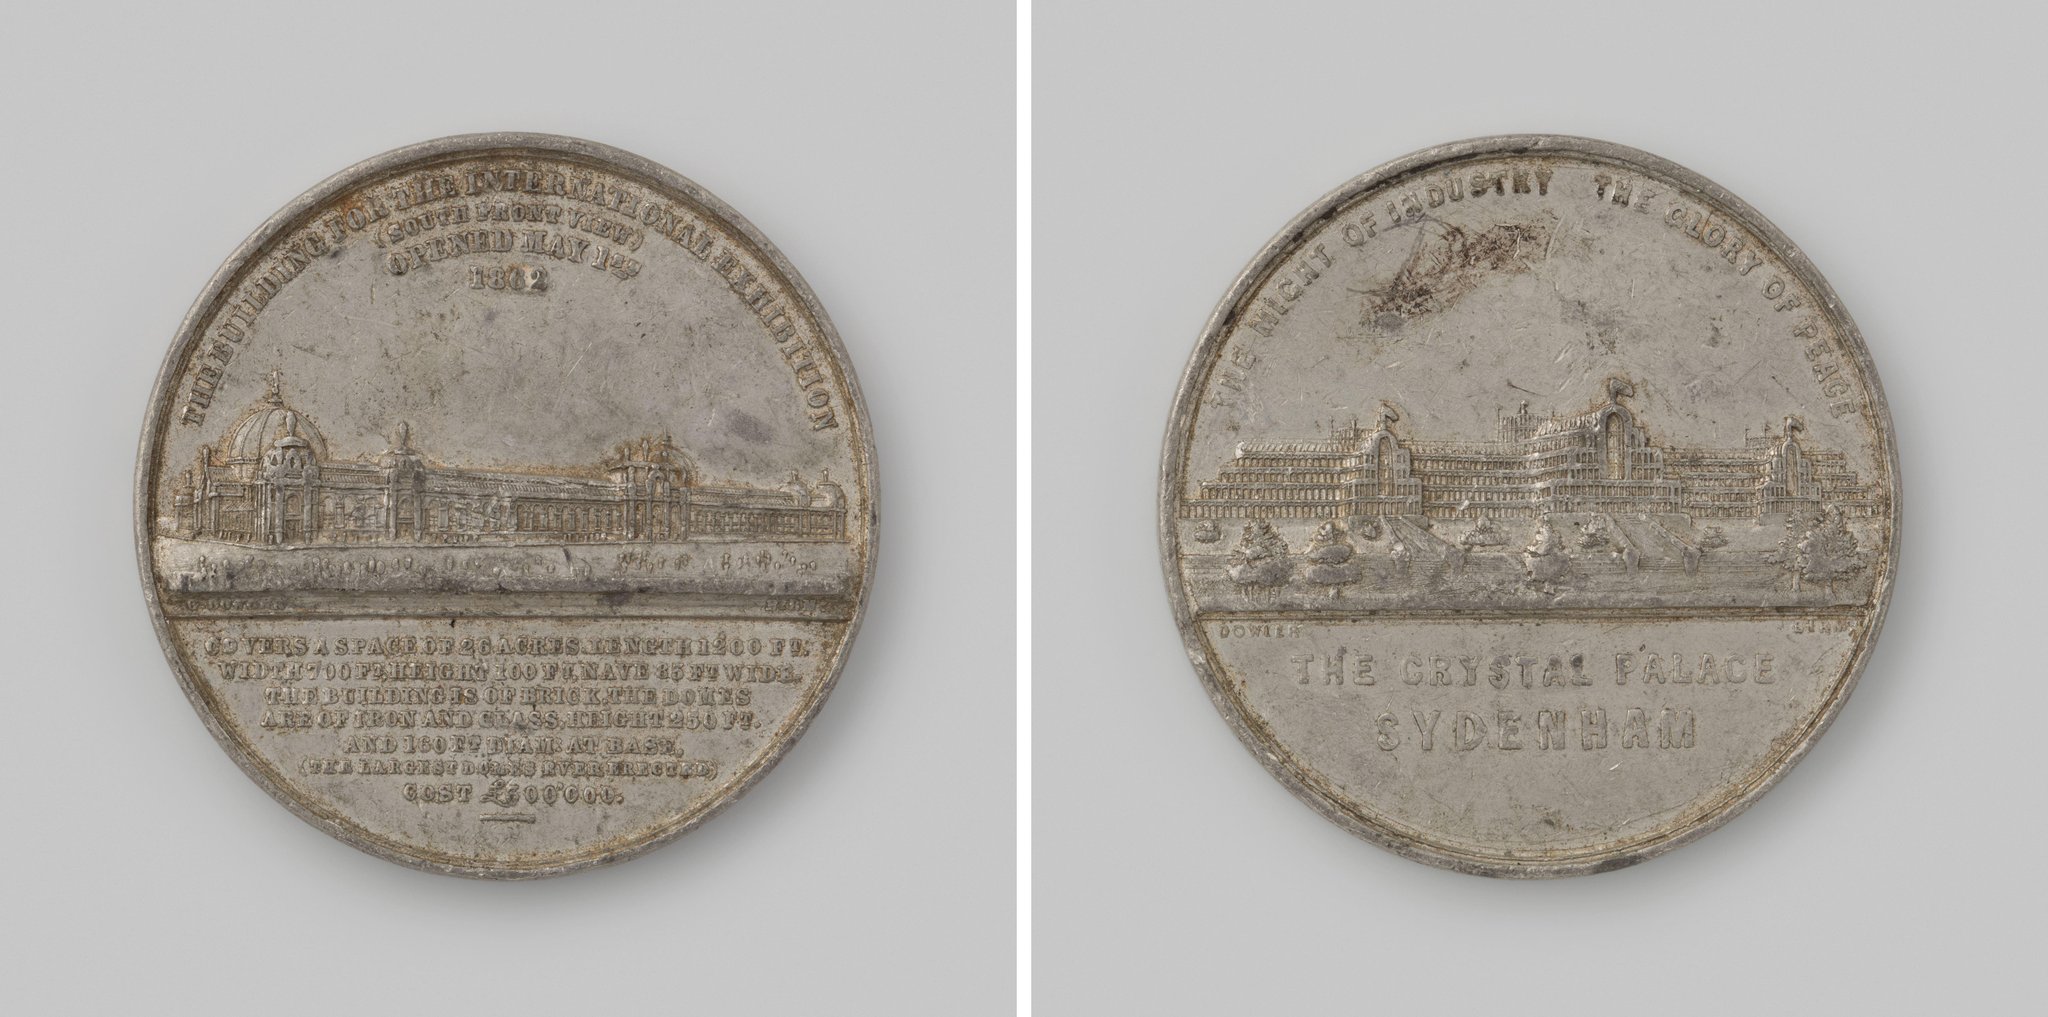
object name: history medal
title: Opening van het tentoonstellingsgebouw van Crystal Palace te Sydenham 1862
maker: george dowler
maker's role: modelleur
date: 1862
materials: tin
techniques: striking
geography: birmingham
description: Tinnen penning, op de voorzijde vier regels tekst, het tentoonstellingsgebouw en zeven regels afsnedetekst, op de keerzijde een regel tekst, het Crystal Palace en twee regels tekst.